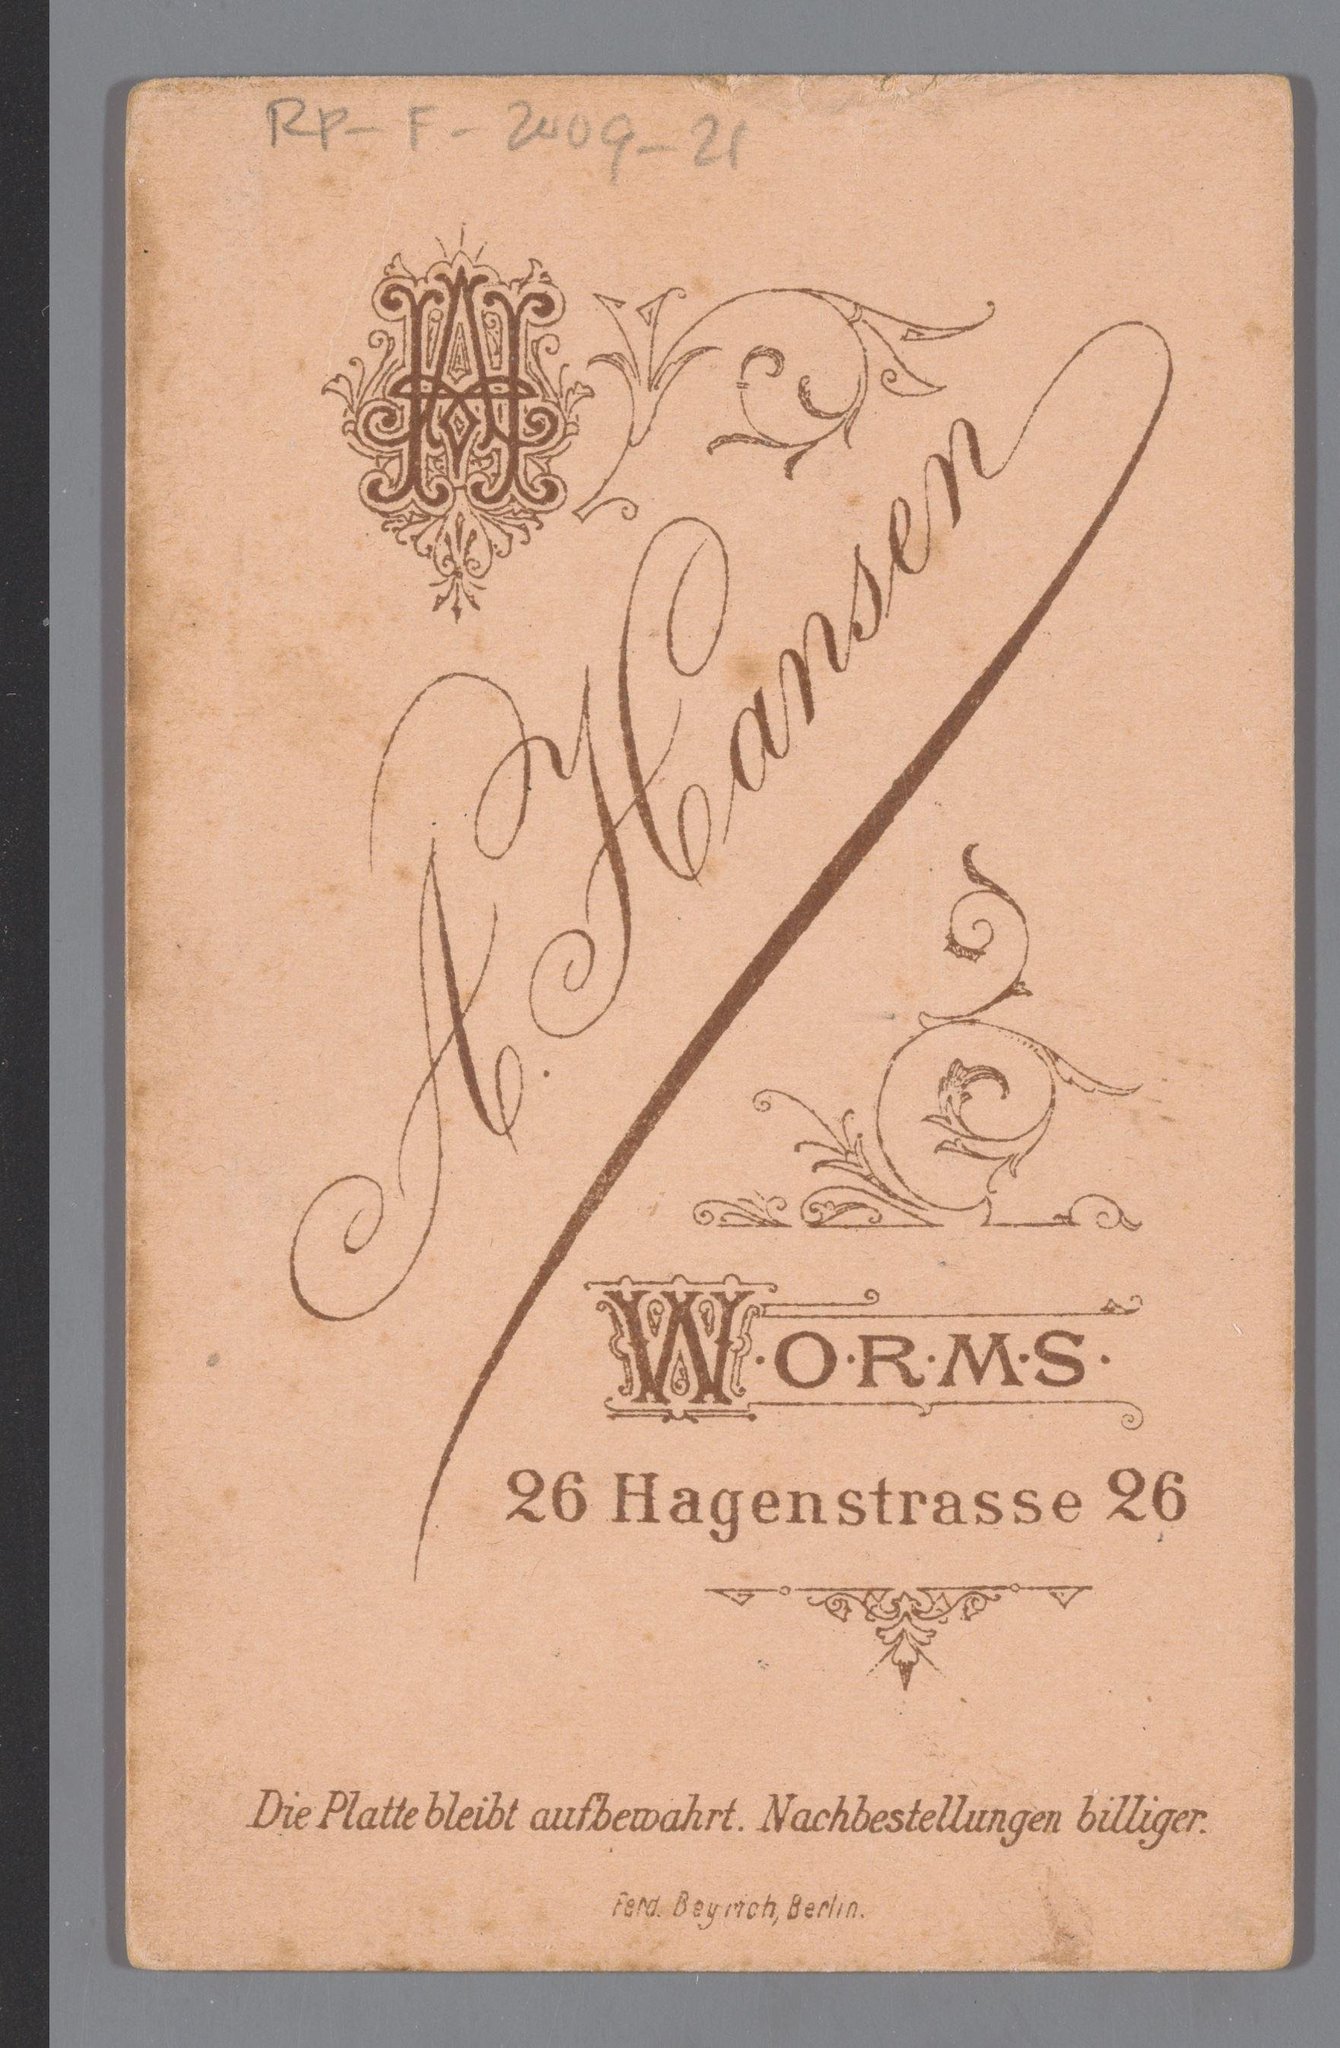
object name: carte de visite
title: Erinnerung an meine Militärzeit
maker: a.j. hansen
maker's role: fotograaf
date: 1895-1910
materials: cardboard, paper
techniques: hand coloring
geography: worms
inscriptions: address: ‘AH // A. Hansen // WORMS // 26 Hagenstrasse 26 // Die Platte bleibt aufbewahrt. Nachbestellungen billiger. // Ferd. Beyrich, Berlin’, address: ‘A. Hansen // Photograph // WORMS // 26 Hagenstrasse 26’, title: ‘Erinnerung an meine Militärzeit’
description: Portret van een dienstplichtige Duitse militair (dezelfde als op RP-F-2009-22), met randversiering van bloemen en een portret.